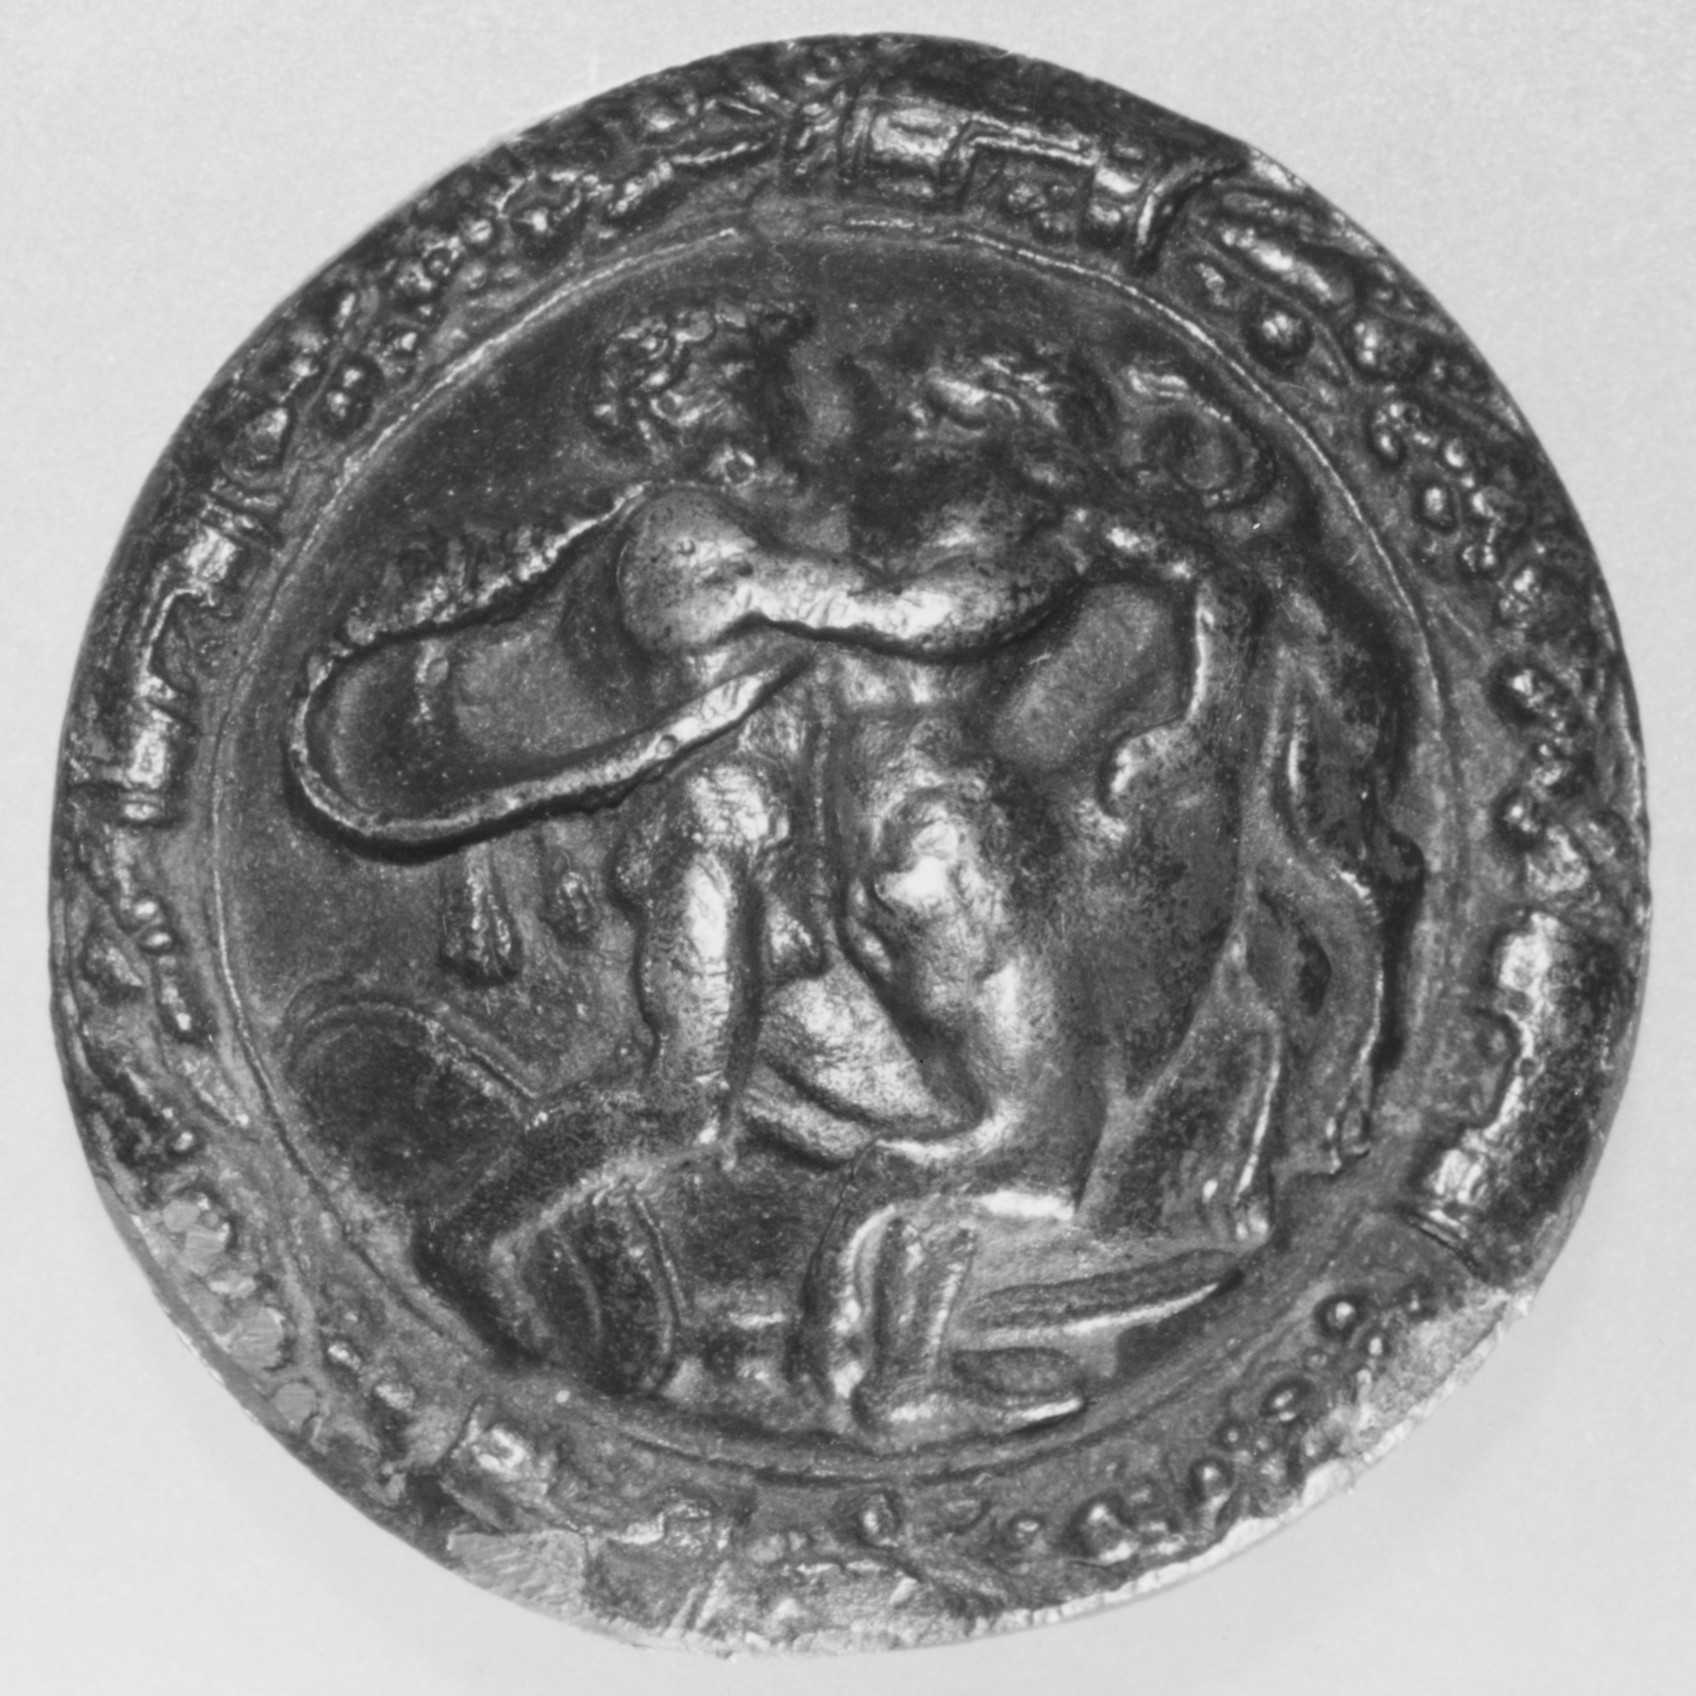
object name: plaquette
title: Hercules and the Centaur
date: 1467-1500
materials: bronze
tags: hercules,centaurs